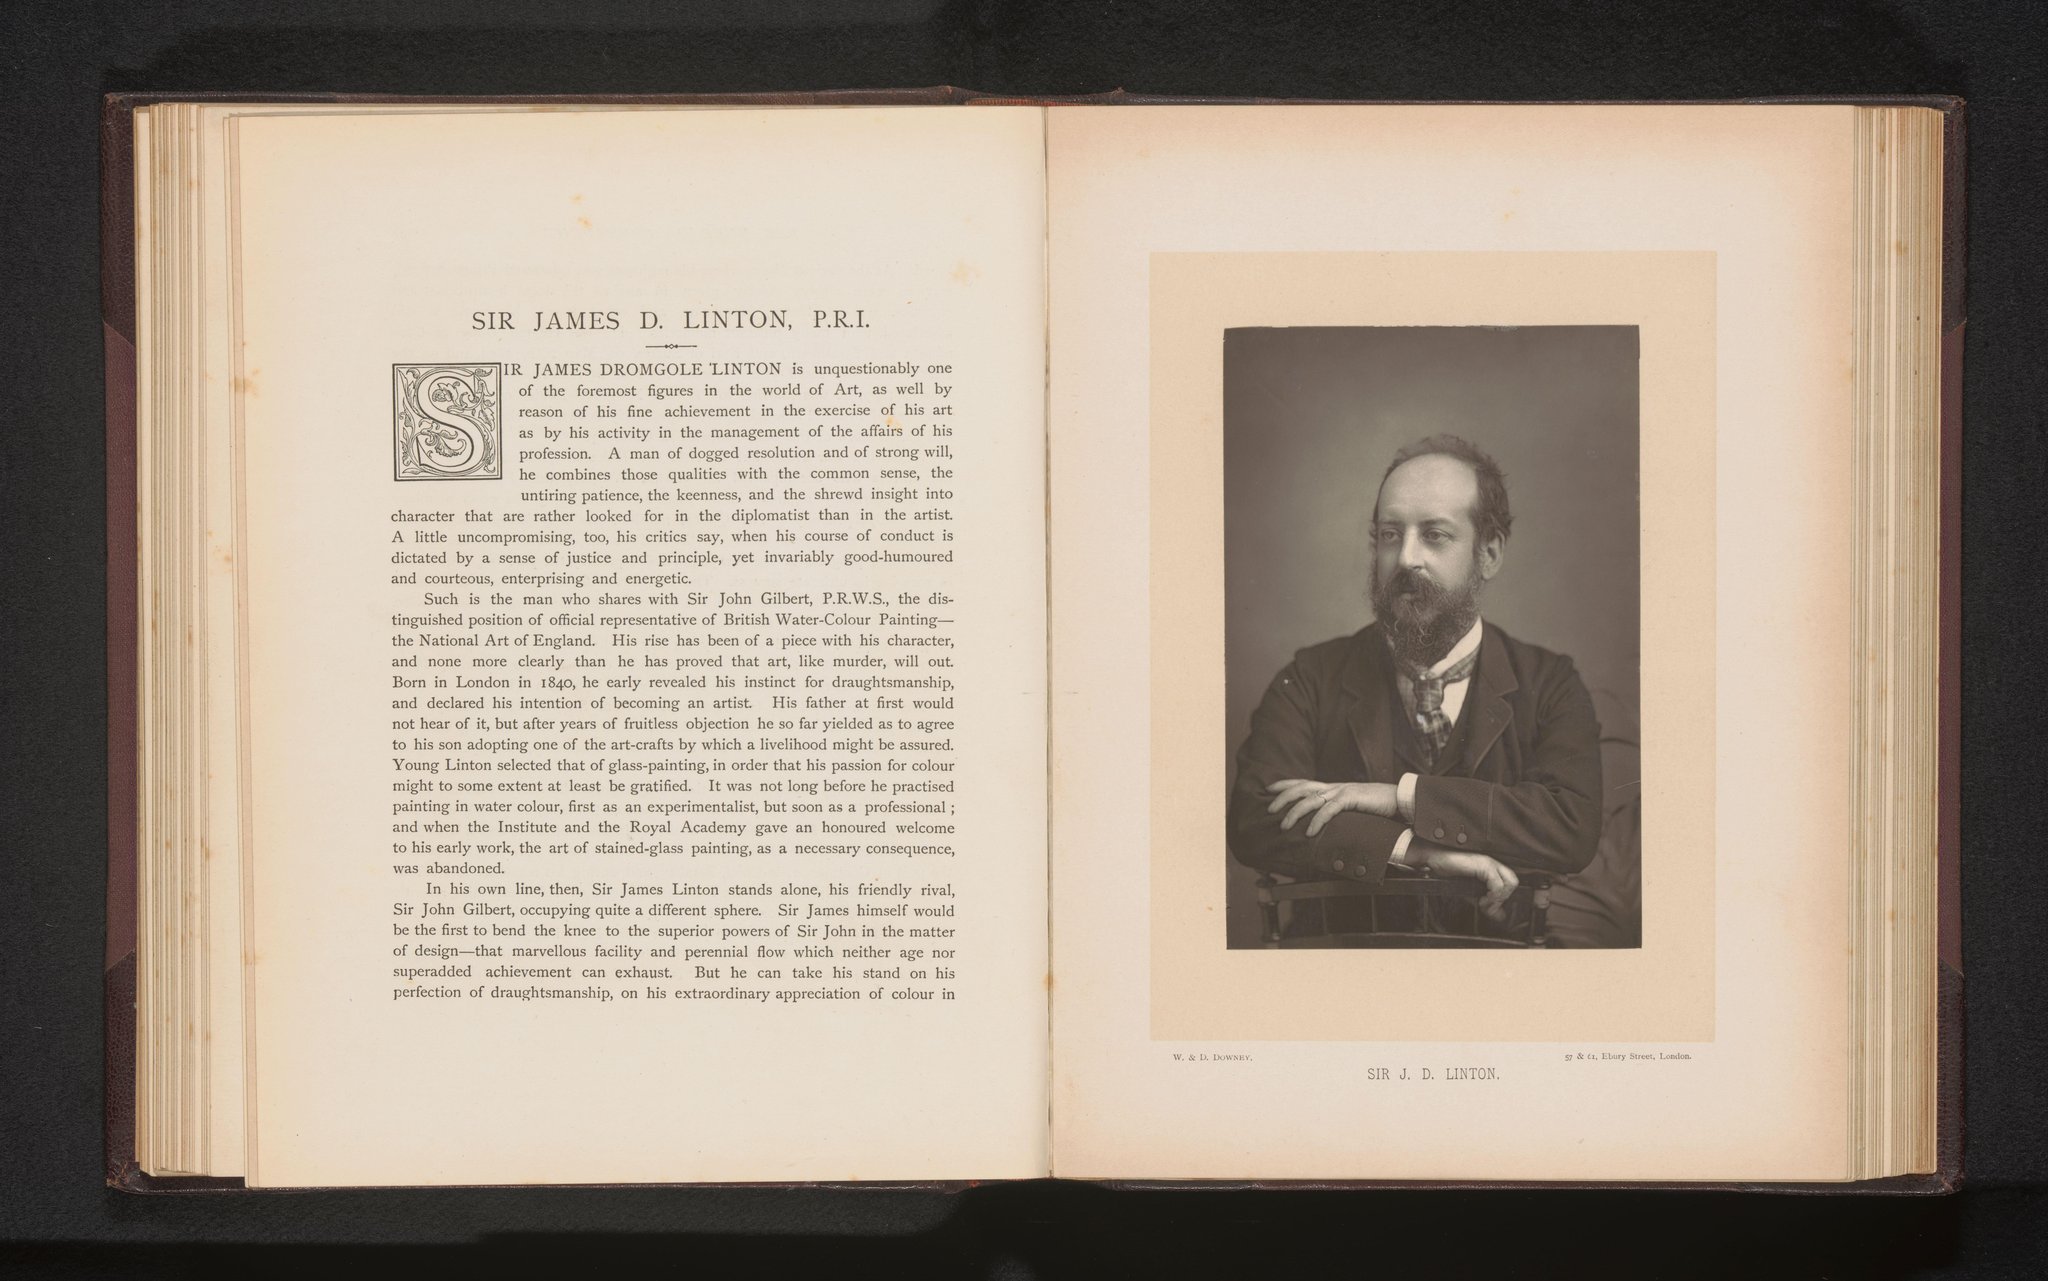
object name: page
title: Portret van James Dromgole Linton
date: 1885-1890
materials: paper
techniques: carbon print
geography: london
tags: historical persons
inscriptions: address: ‘57 & 61, Ebury Street, London.’